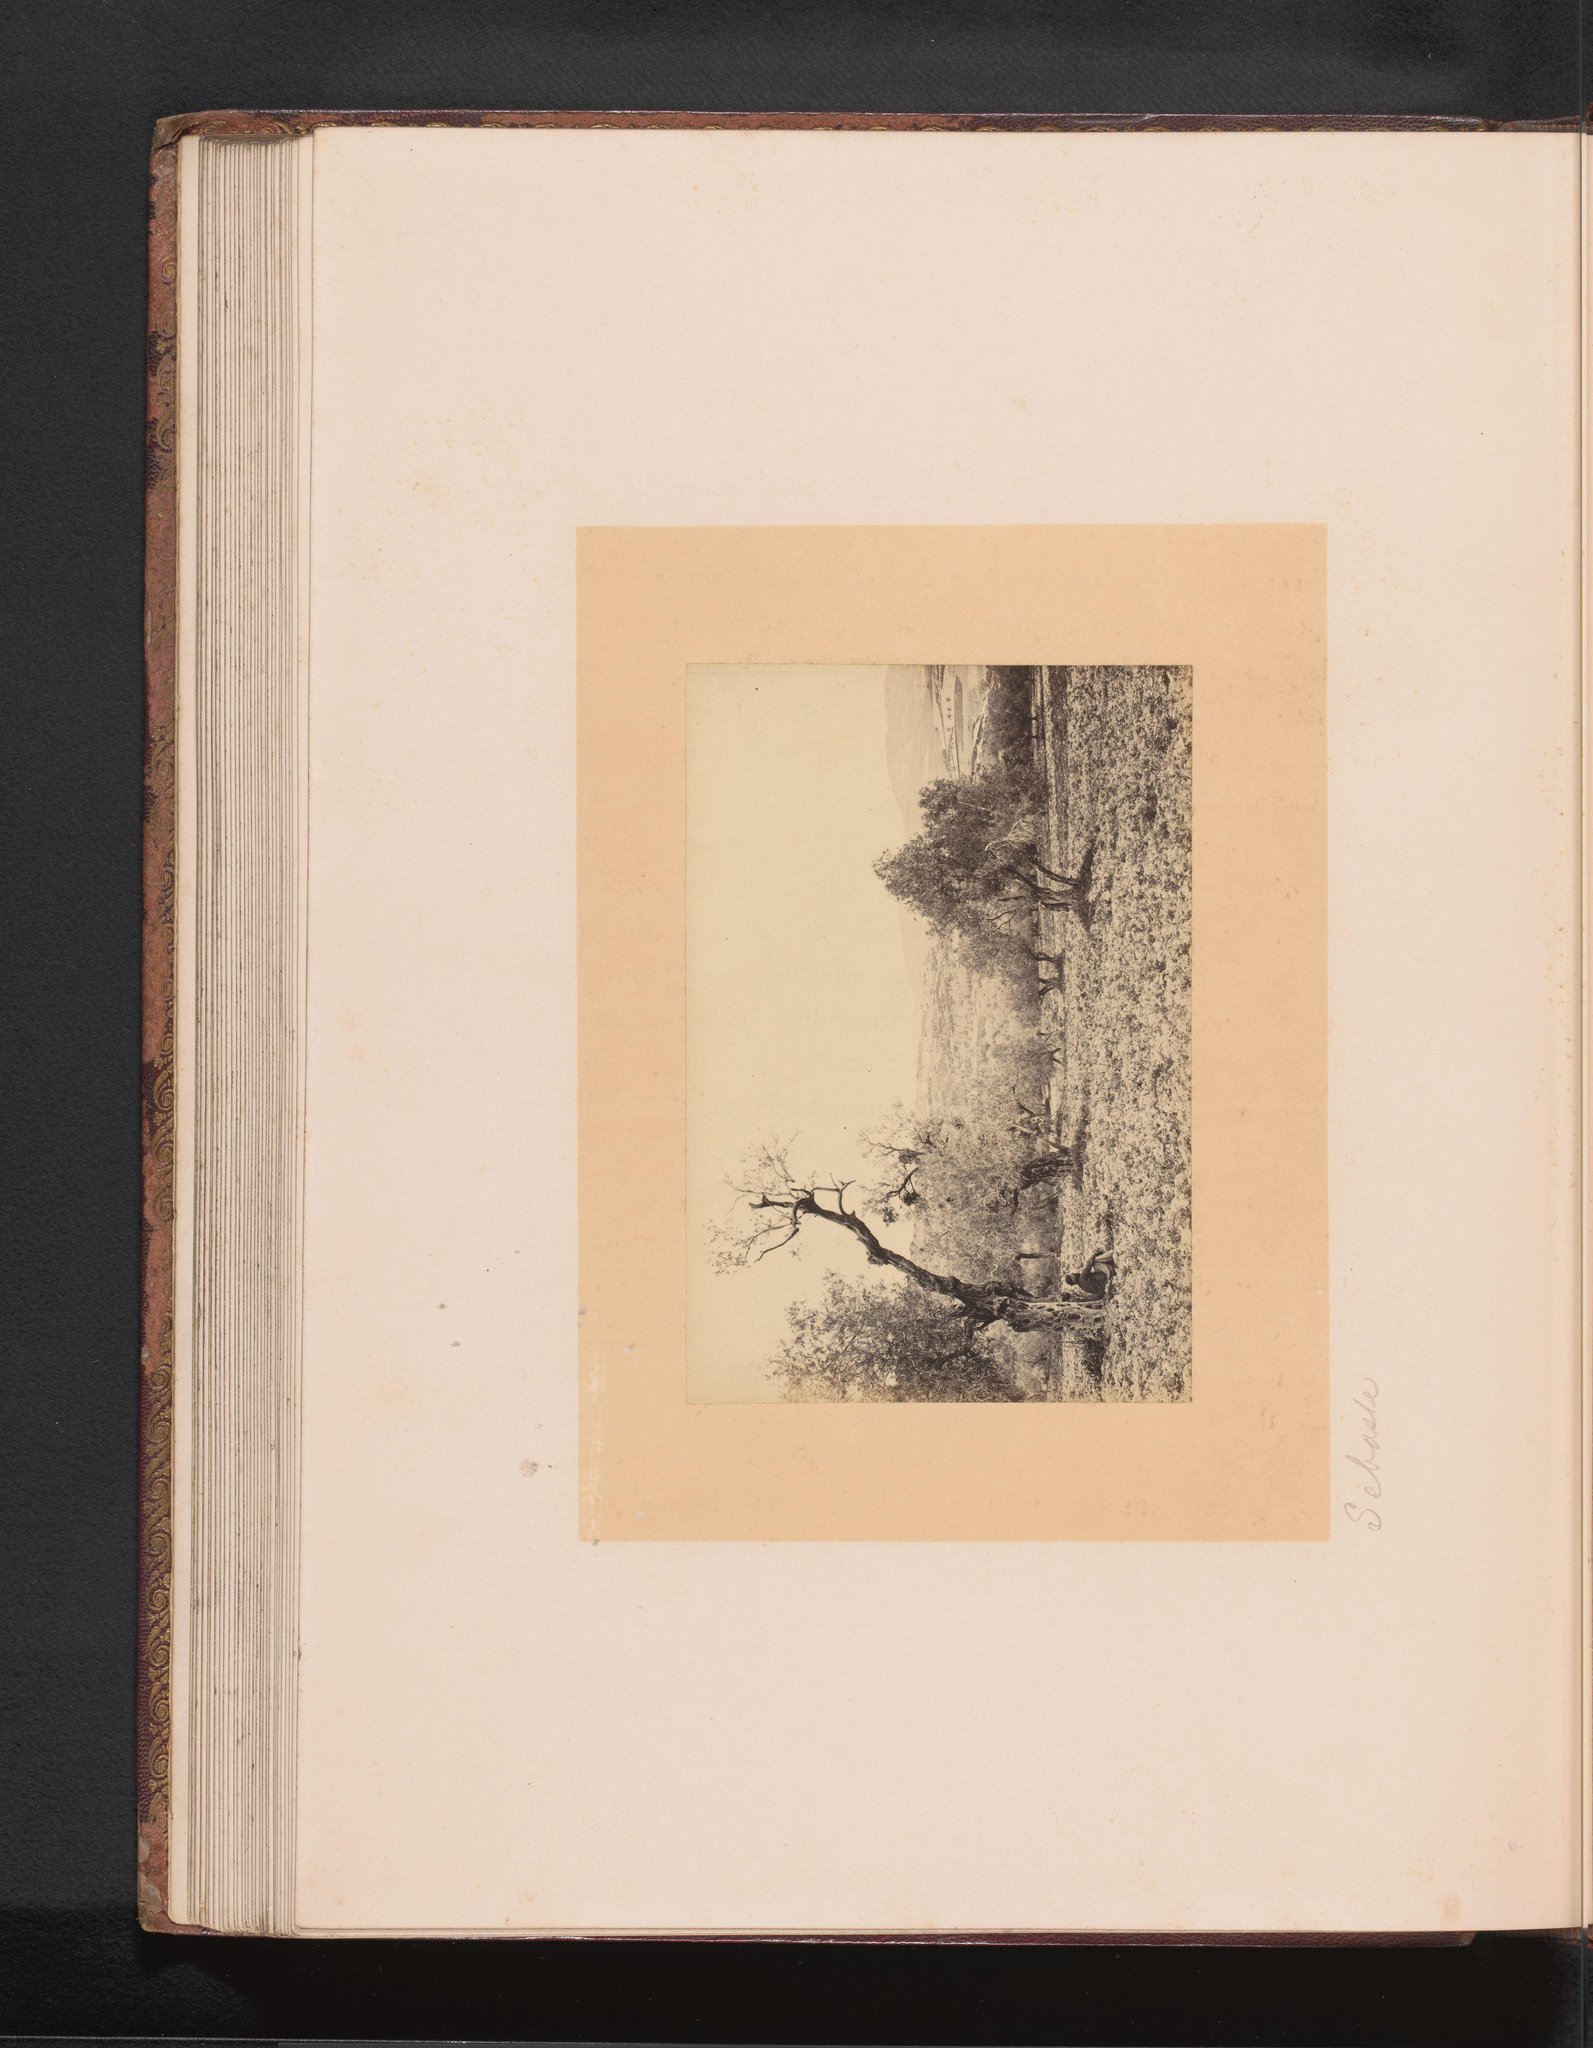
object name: page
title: Gezicht op Samaria of Sebastia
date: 1870-1875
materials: photographic support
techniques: albumen print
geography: samaria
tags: desert - kk - ideal landscapes (+ landscape (in the non-temperate zone) with figures, staffage)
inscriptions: annotation: ‘Sebaste’